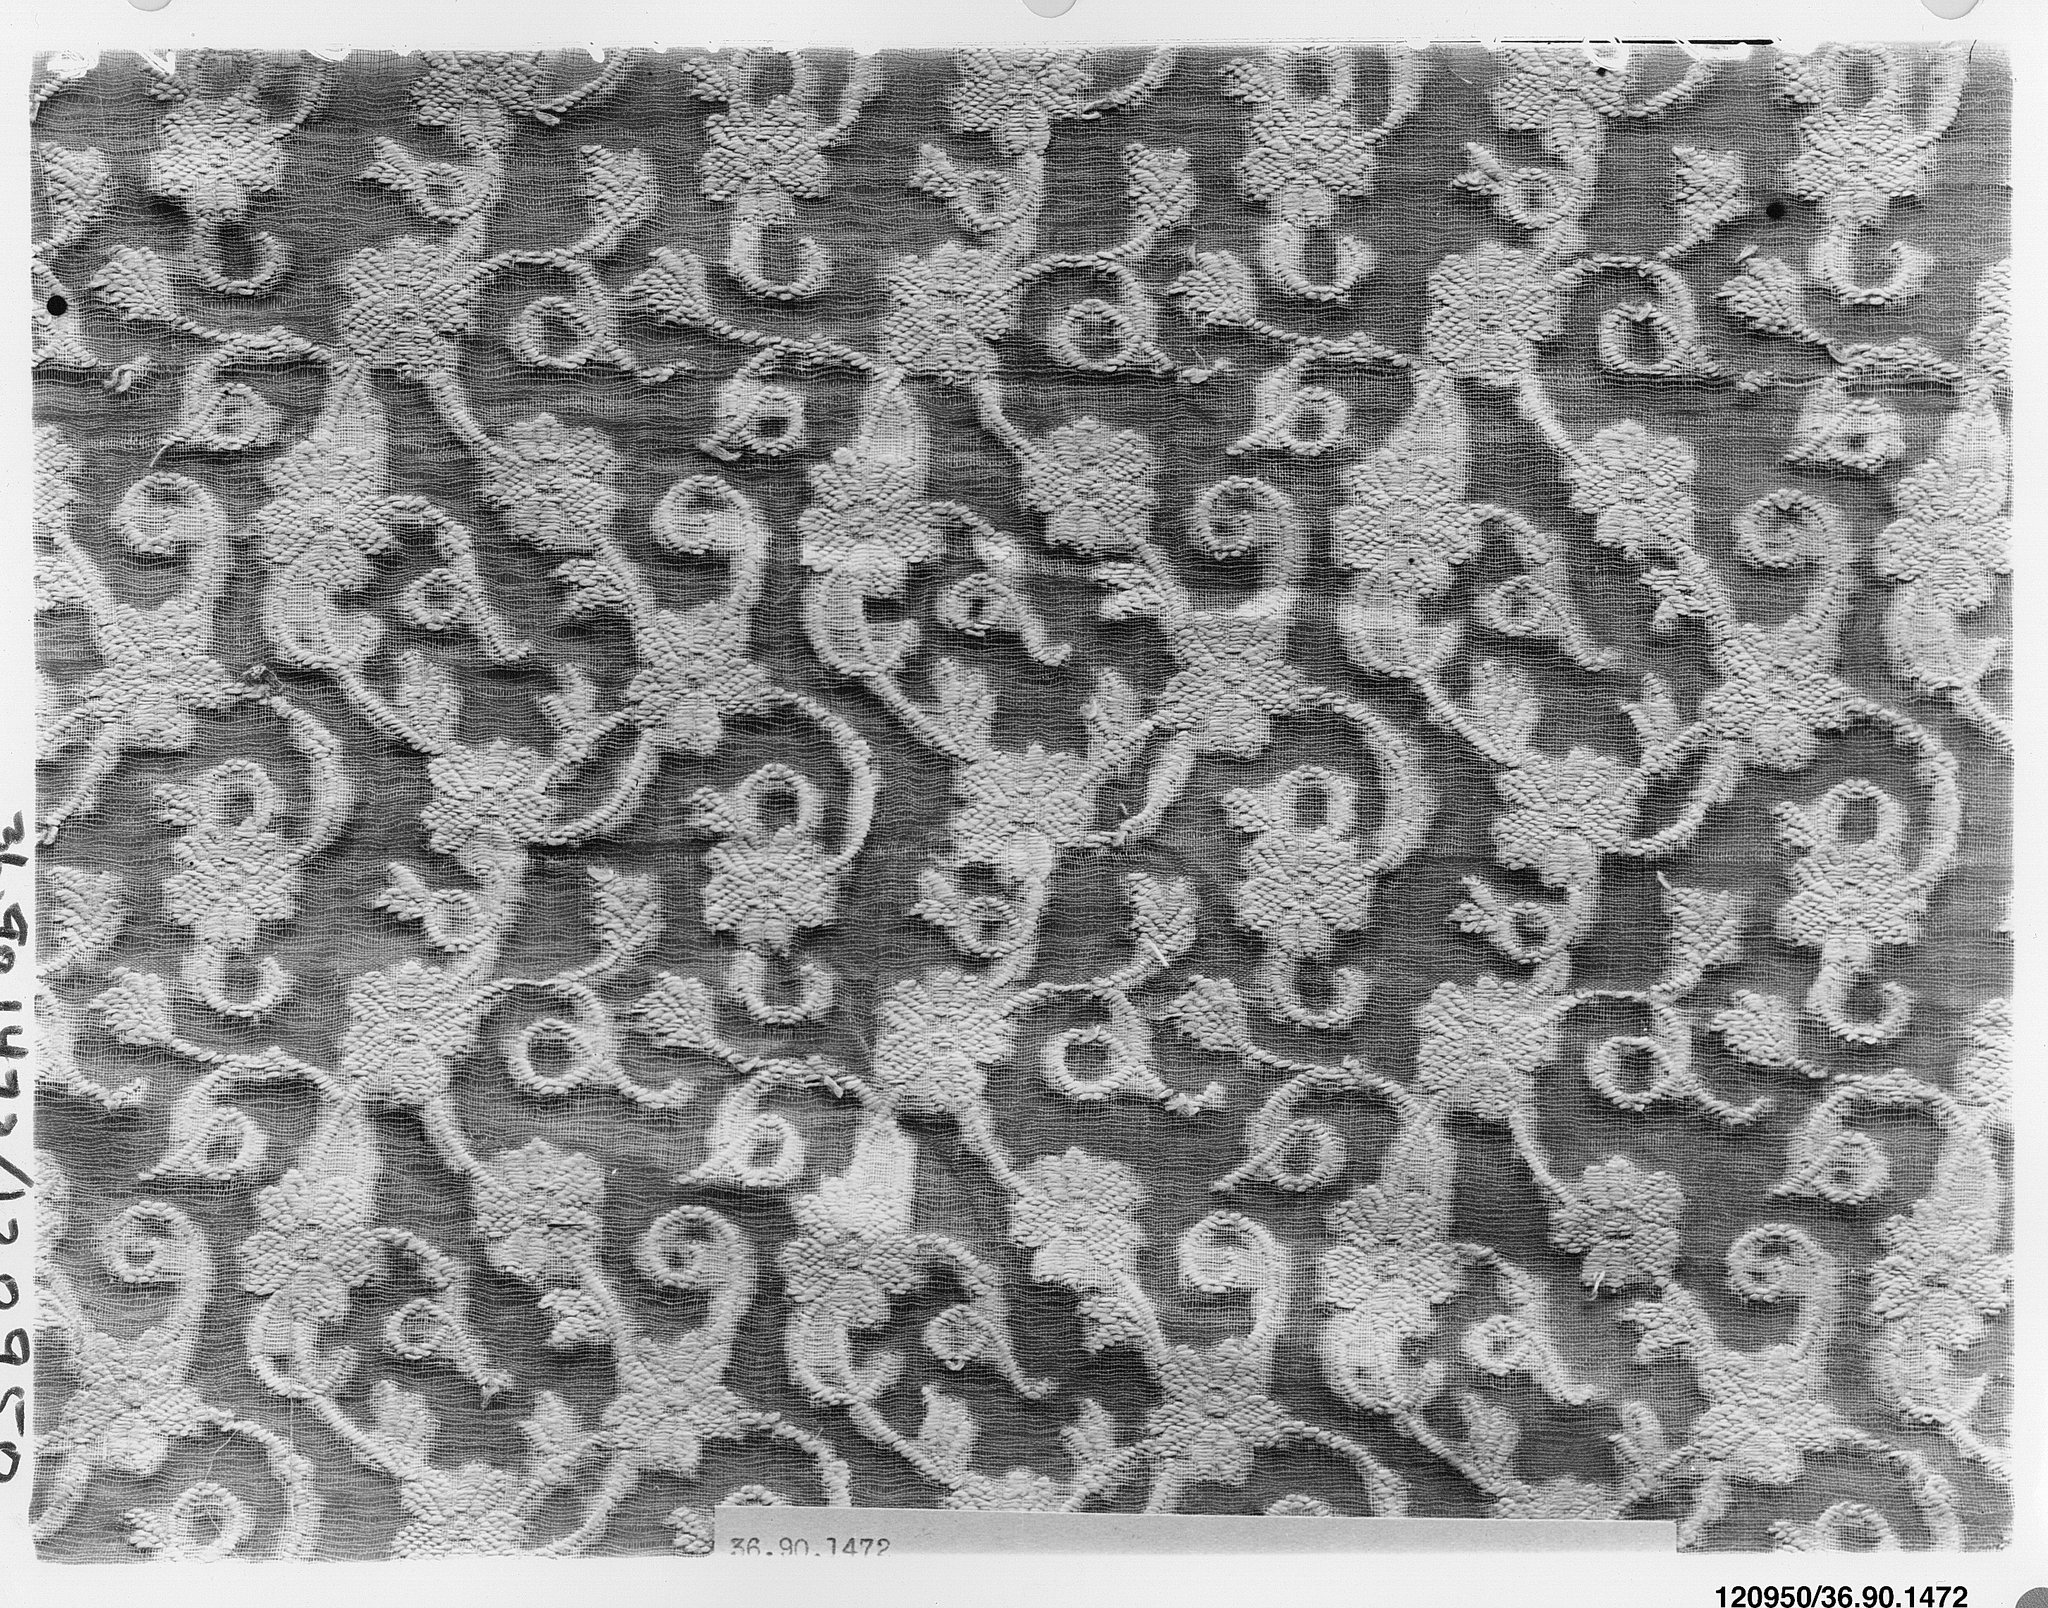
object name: piece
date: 1801-1900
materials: cotton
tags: flowers,leaves